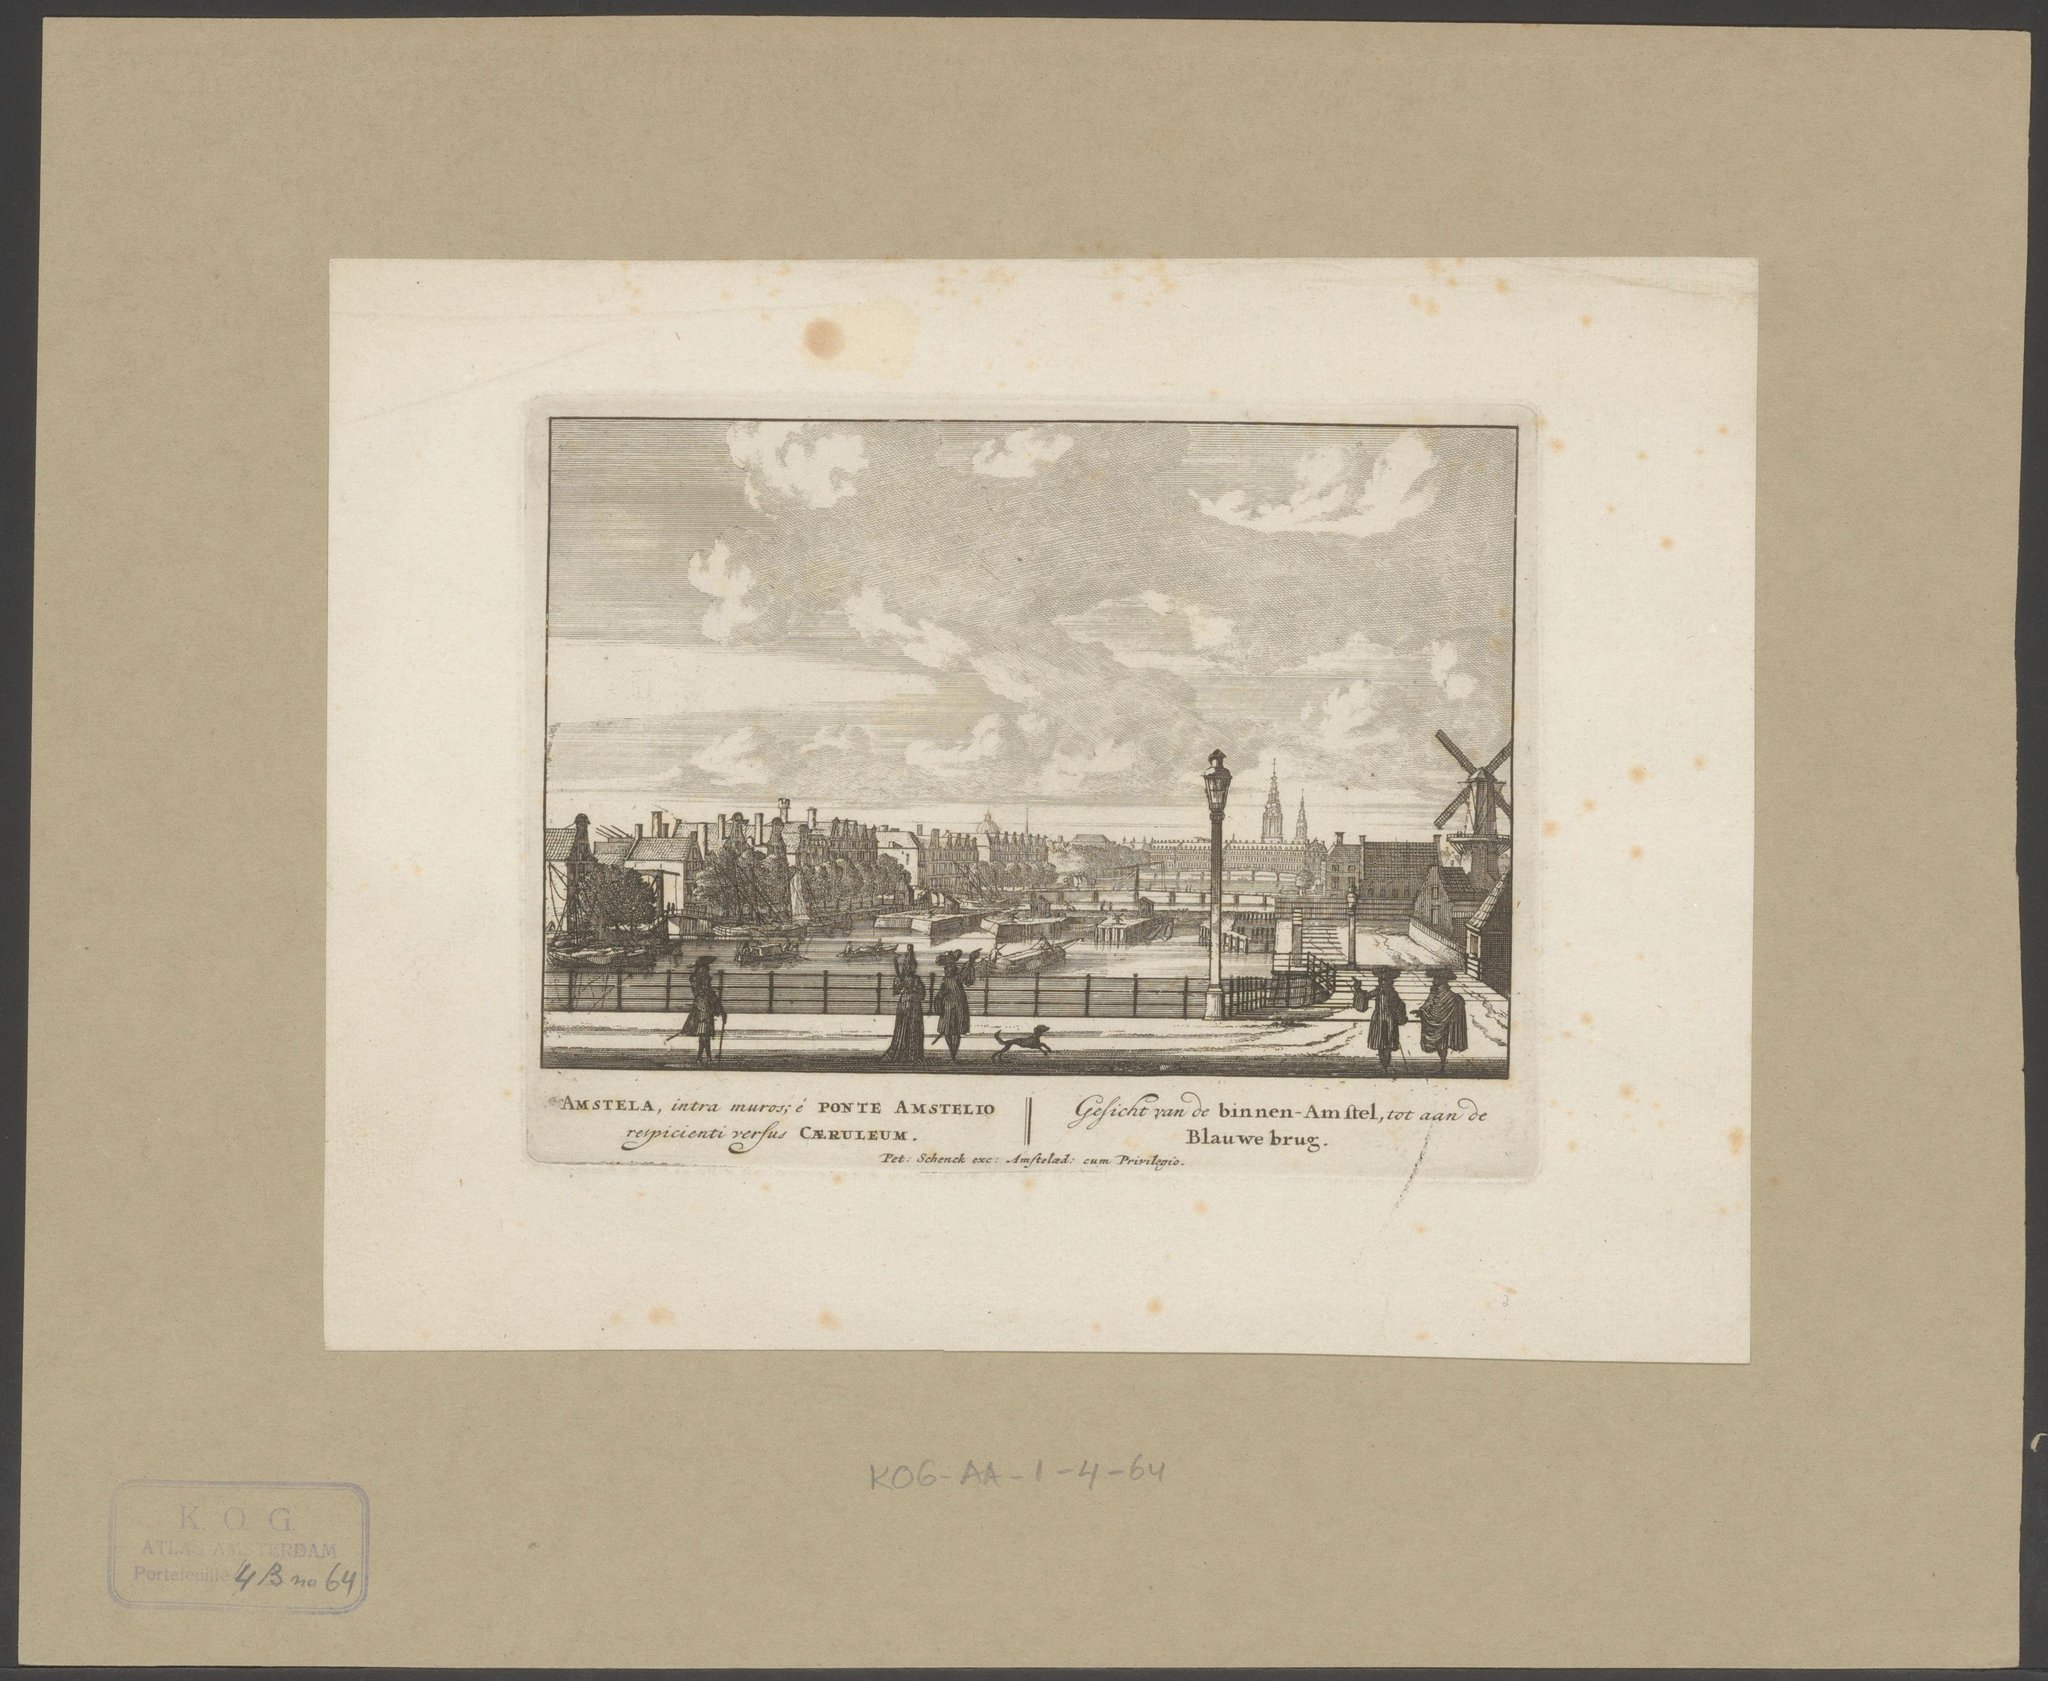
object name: print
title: Amstela, intra muros; é ponte Amstelio respicienti versus Caeruleum / Gesicht van de Binnen-Amstel tot aan de Blauwe brug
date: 1694-1697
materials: paper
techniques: etching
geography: amsterdam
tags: city-view in general; 'veduta', canal, windmill in landscape, bridge in city across river, canal, etc.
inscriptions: collector's mark: ‘4B no64’ Lugt 1641b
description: Prent waarschijnlijk uit: Call, Jan van. Admirandorum Quadruplex Spectaculum. Amsterdam: Pieter Schenk (I), 1700. De titelprent, opdracht en het portret van Frederik van Saksen zijn gegraveerd door Pieter Schenk (I). De overige prenten uit deze serie zijn, zoals aangegeven op de titelprent, van de hand van Jan van Call (I).